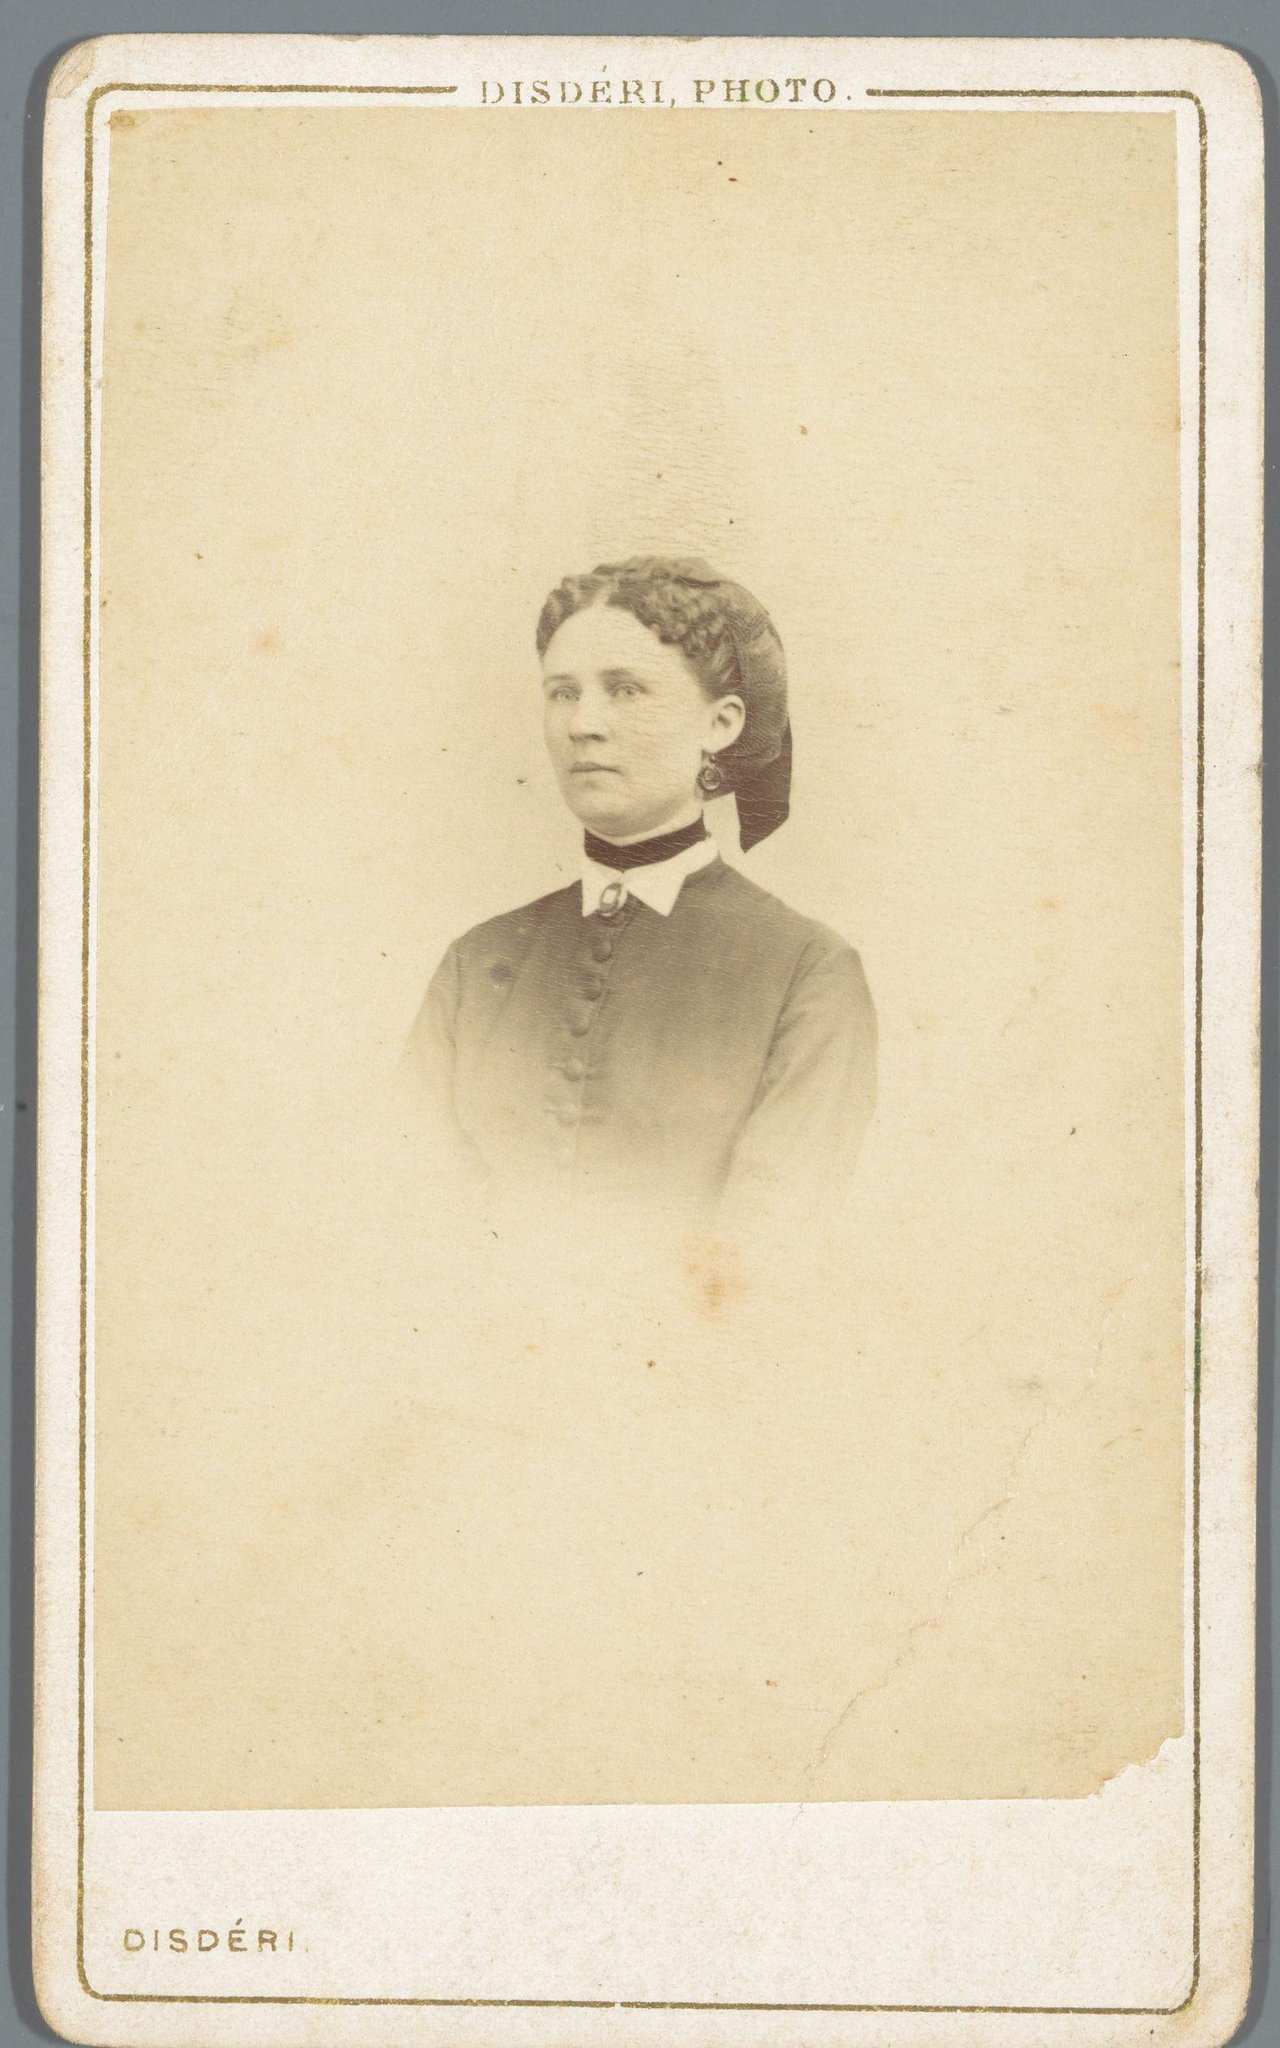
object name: carte de visite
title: Cartes-de-visite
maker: andré-adolphe-eugène disdéri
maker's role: fotograaf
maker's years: 1819-1889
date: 1854-1889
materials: cardboard, paper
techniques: albumen print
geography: paris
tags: historical persons - bb - woman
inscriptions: inscription: ‘Disderi/ PARIS, 8, Boulevard des Italiens’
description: Cartomanie was a collecting craze. From 1855 hundreds of thousands of these portraits were annually sold worldwide. People had photographs taken of their loved ones, including their pets, and kept them in an album. Portraits of kings, writers, artists, actors, and statesmen were also collected. Photography was no longer the preserve of the wealthy; farmers and maidservants now also stood before the camera.